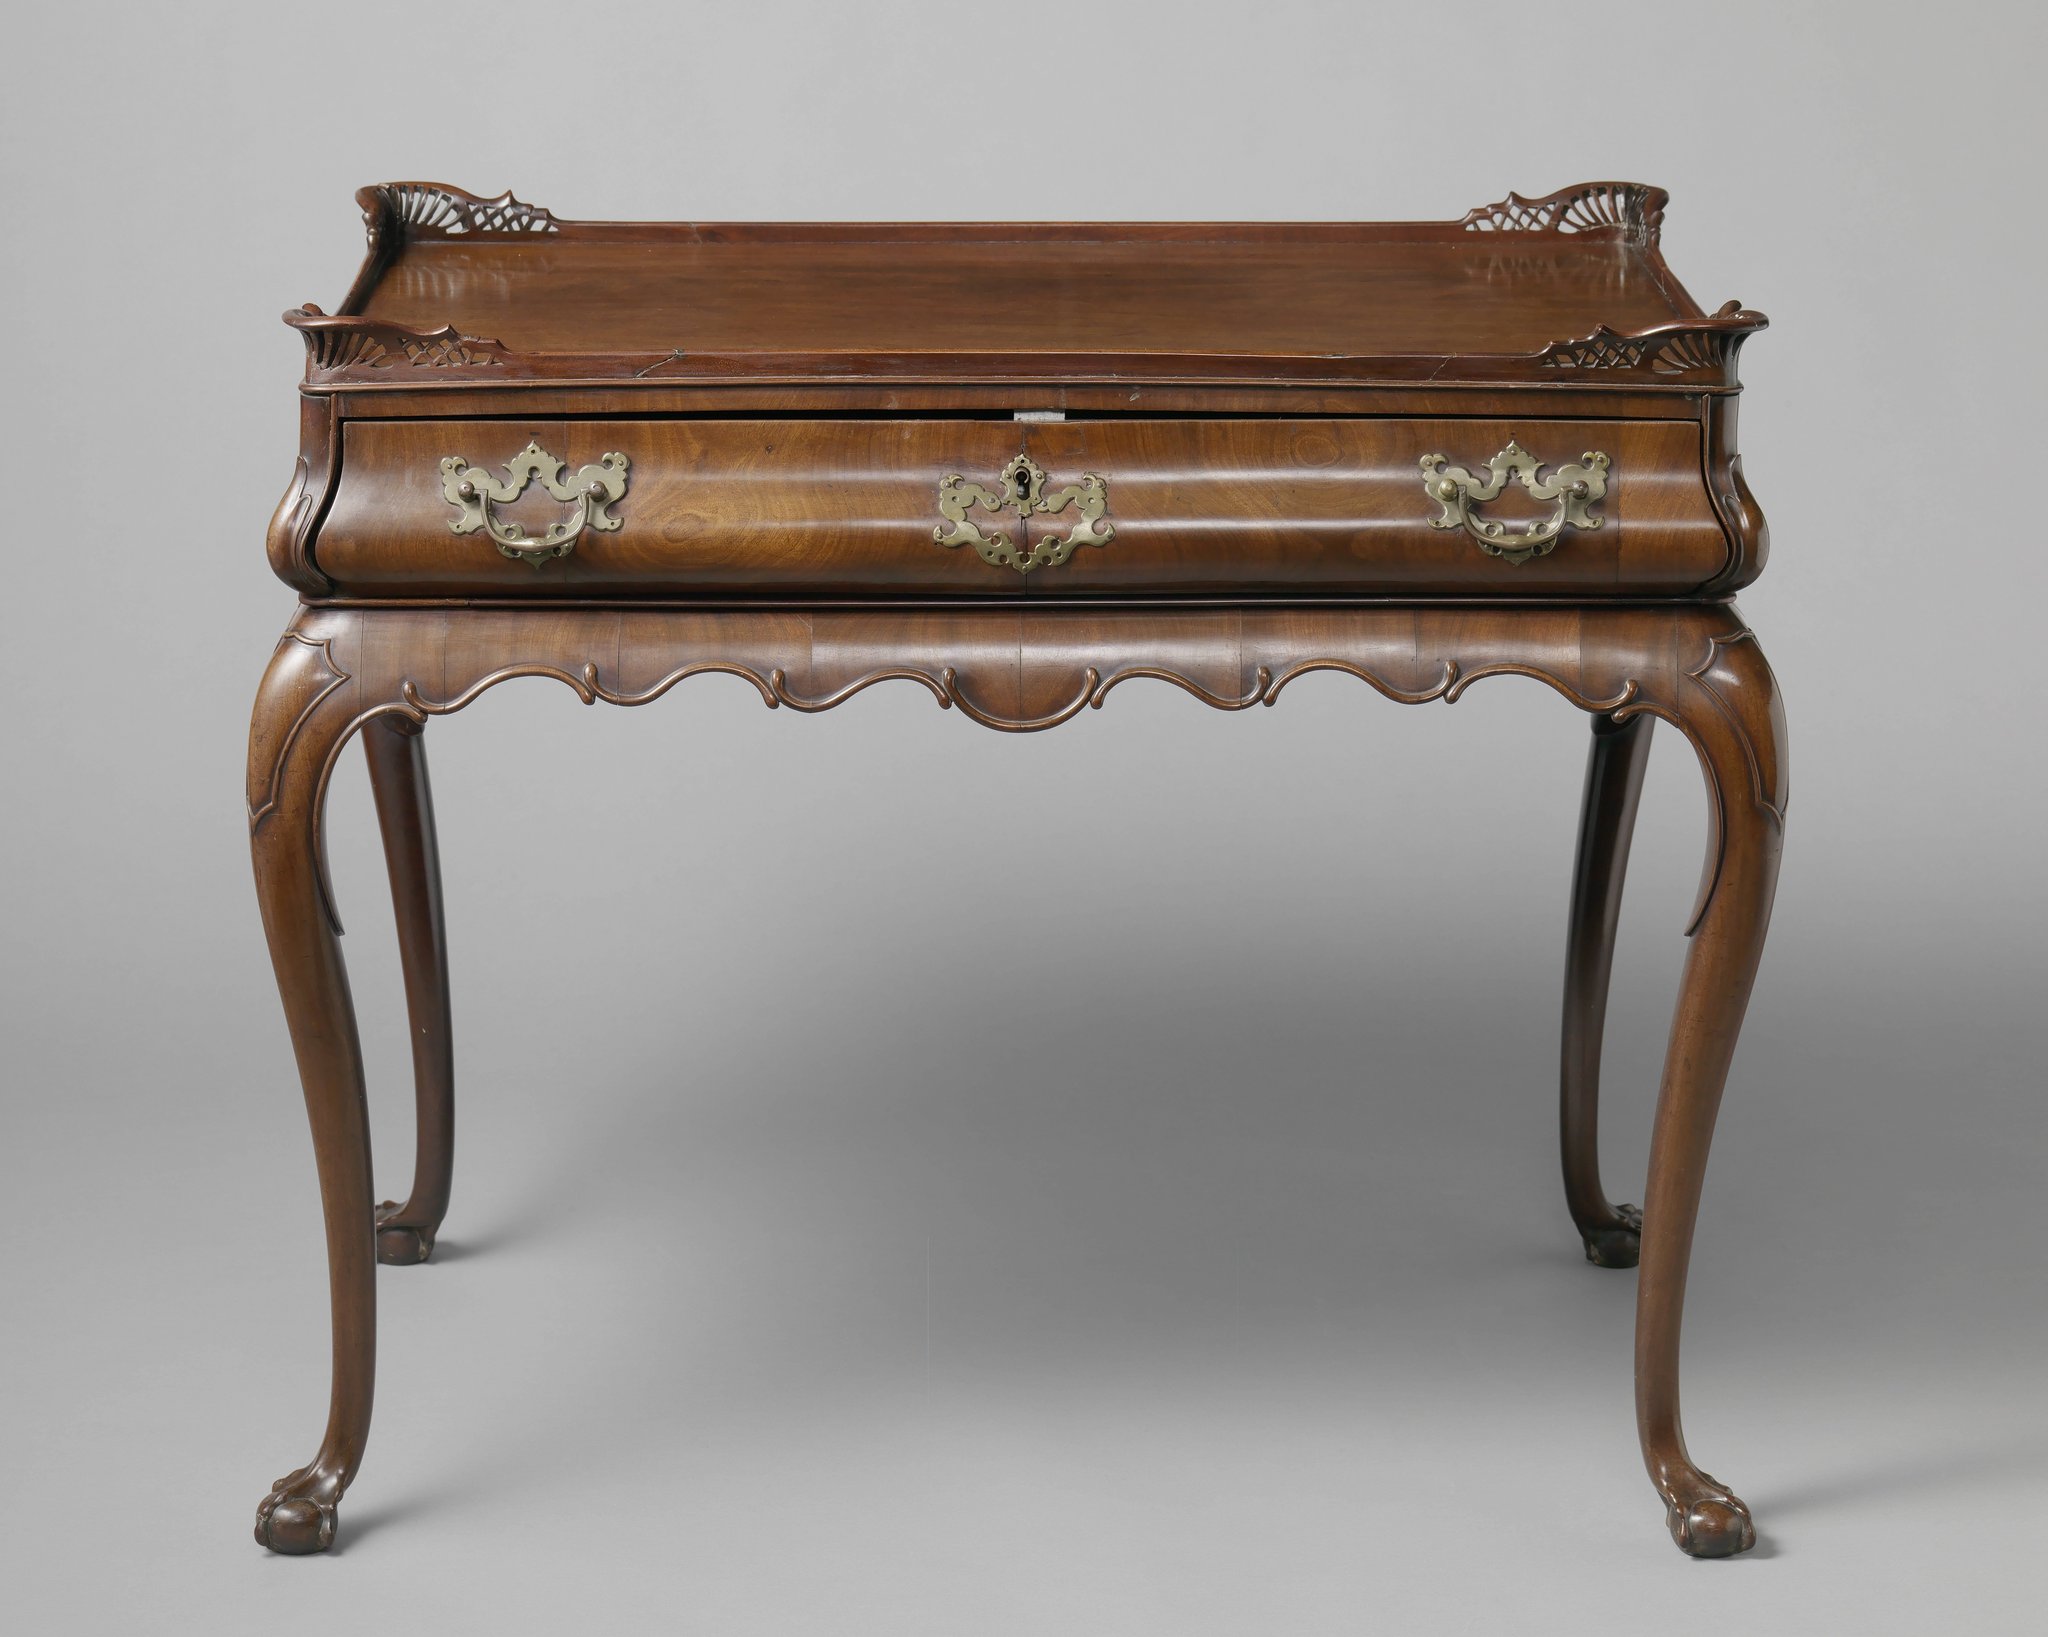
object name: table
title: Tea table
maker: Anonymous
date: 1750-1775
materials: copper, wood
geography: netherlands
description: The 18th century saw the development of more and more furniture types for specific uses. This tea table has a raised edge to stop the tea set from falling off. The raised, openwork corners have a Chinese-looking pattern, a reference to the country from which tea originated.